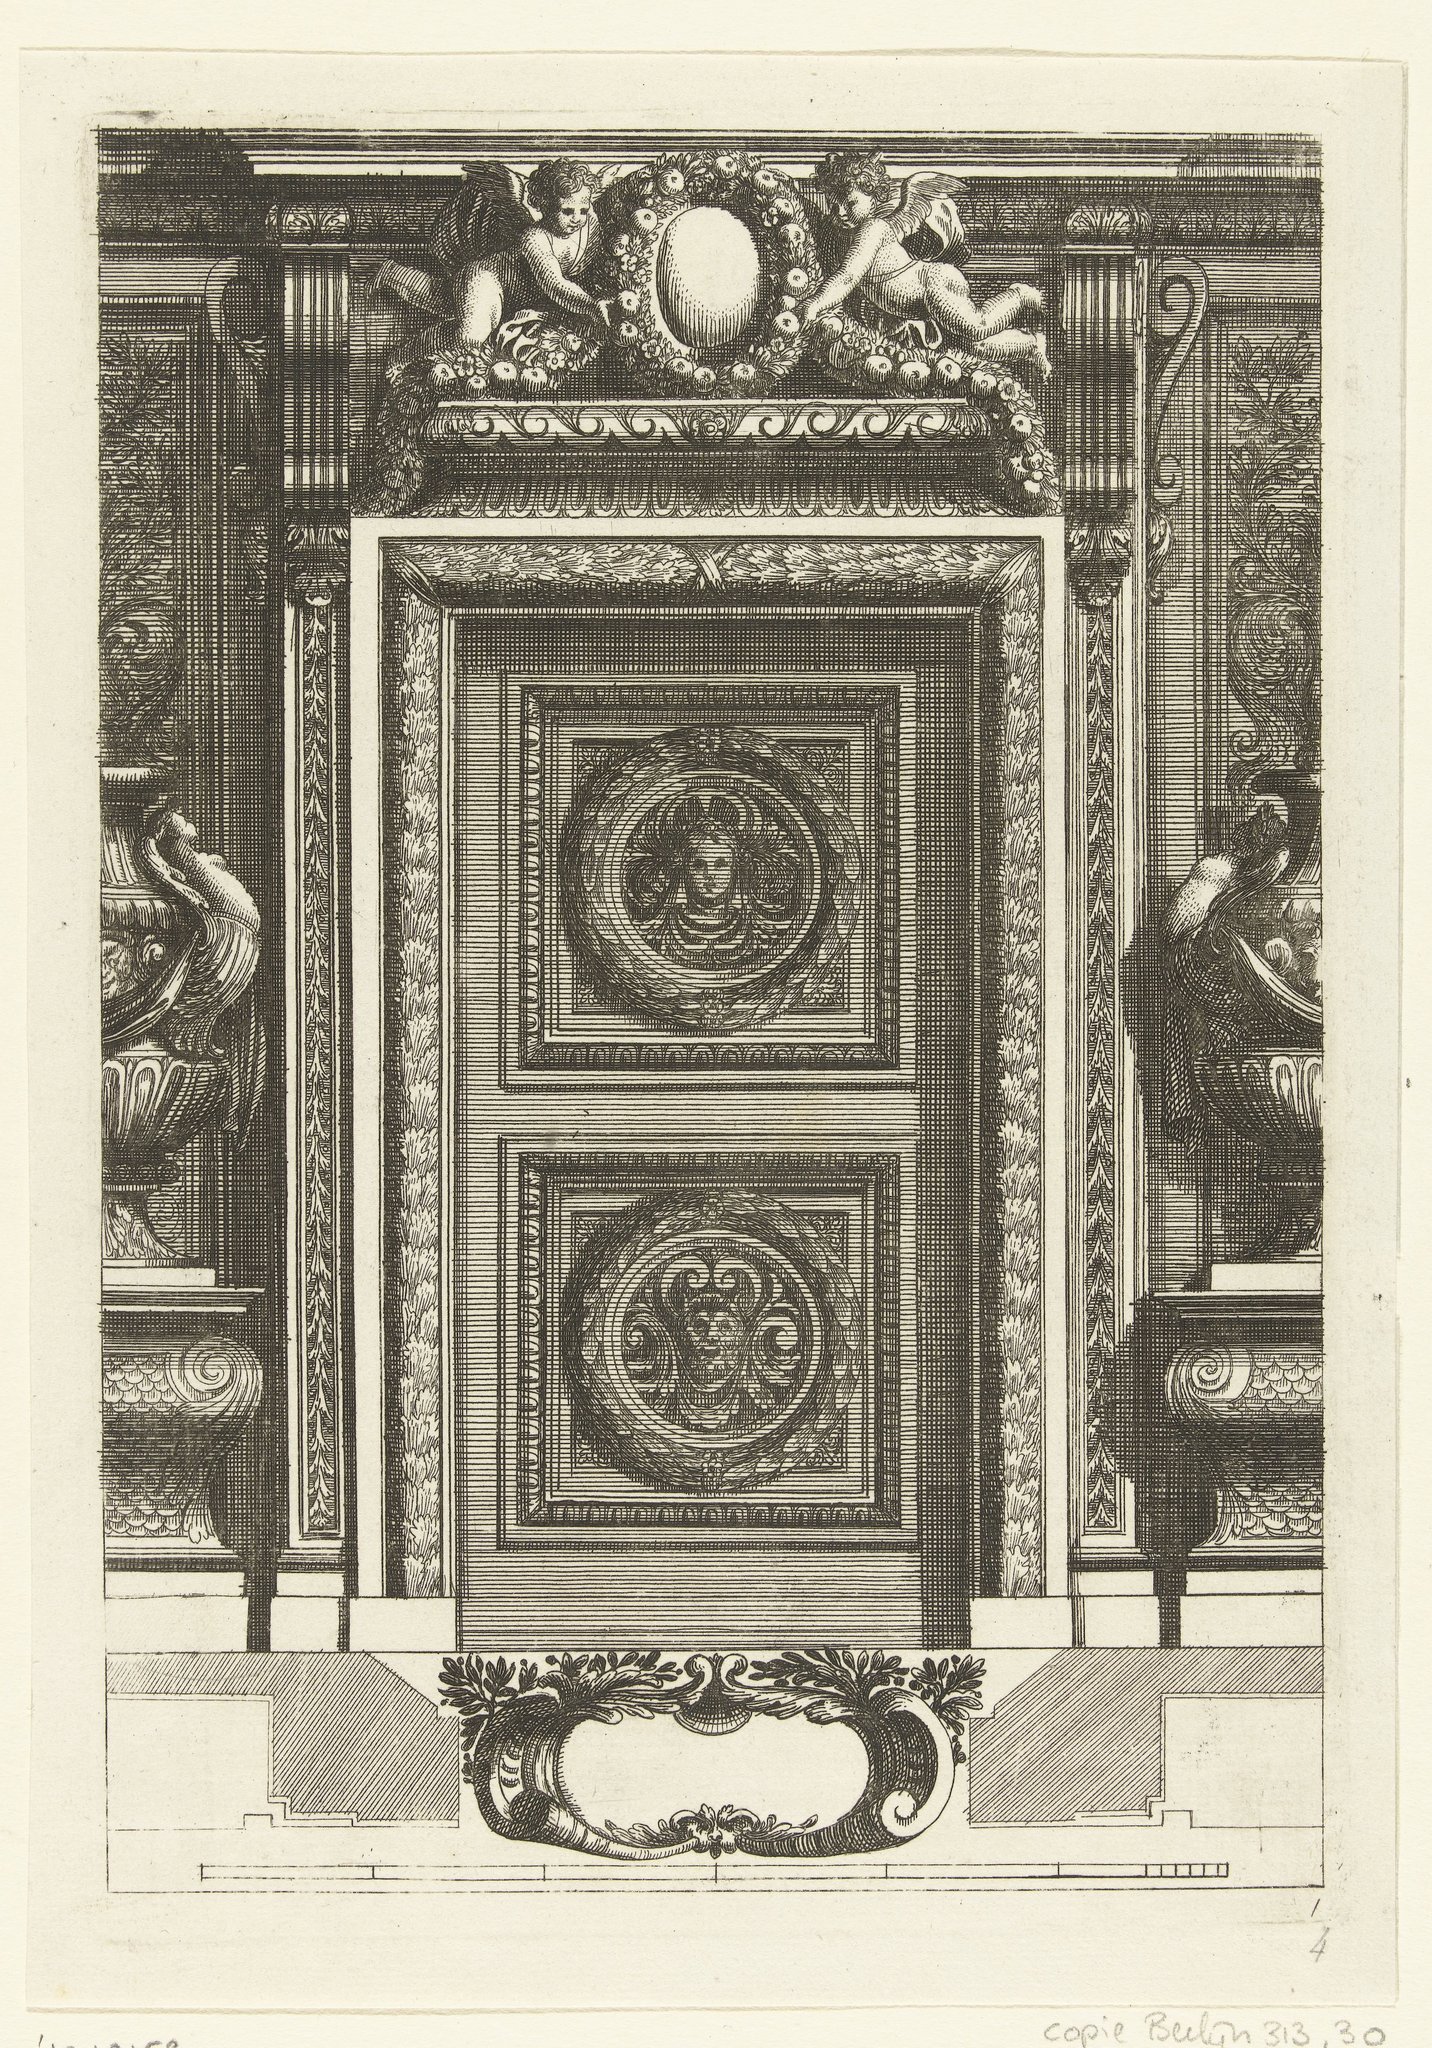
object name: ornament print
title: Scartaffii overo ornamenti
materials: paper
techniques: engraving, etching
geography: antwerp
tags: door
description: Beide panelen zijn gedecoreerd met een rond medaillon met een mascaron. Opstand en plan onderaan. Uit serie van 6 bladen met ornamentele panelen en deuren voor kamers en alkoven.